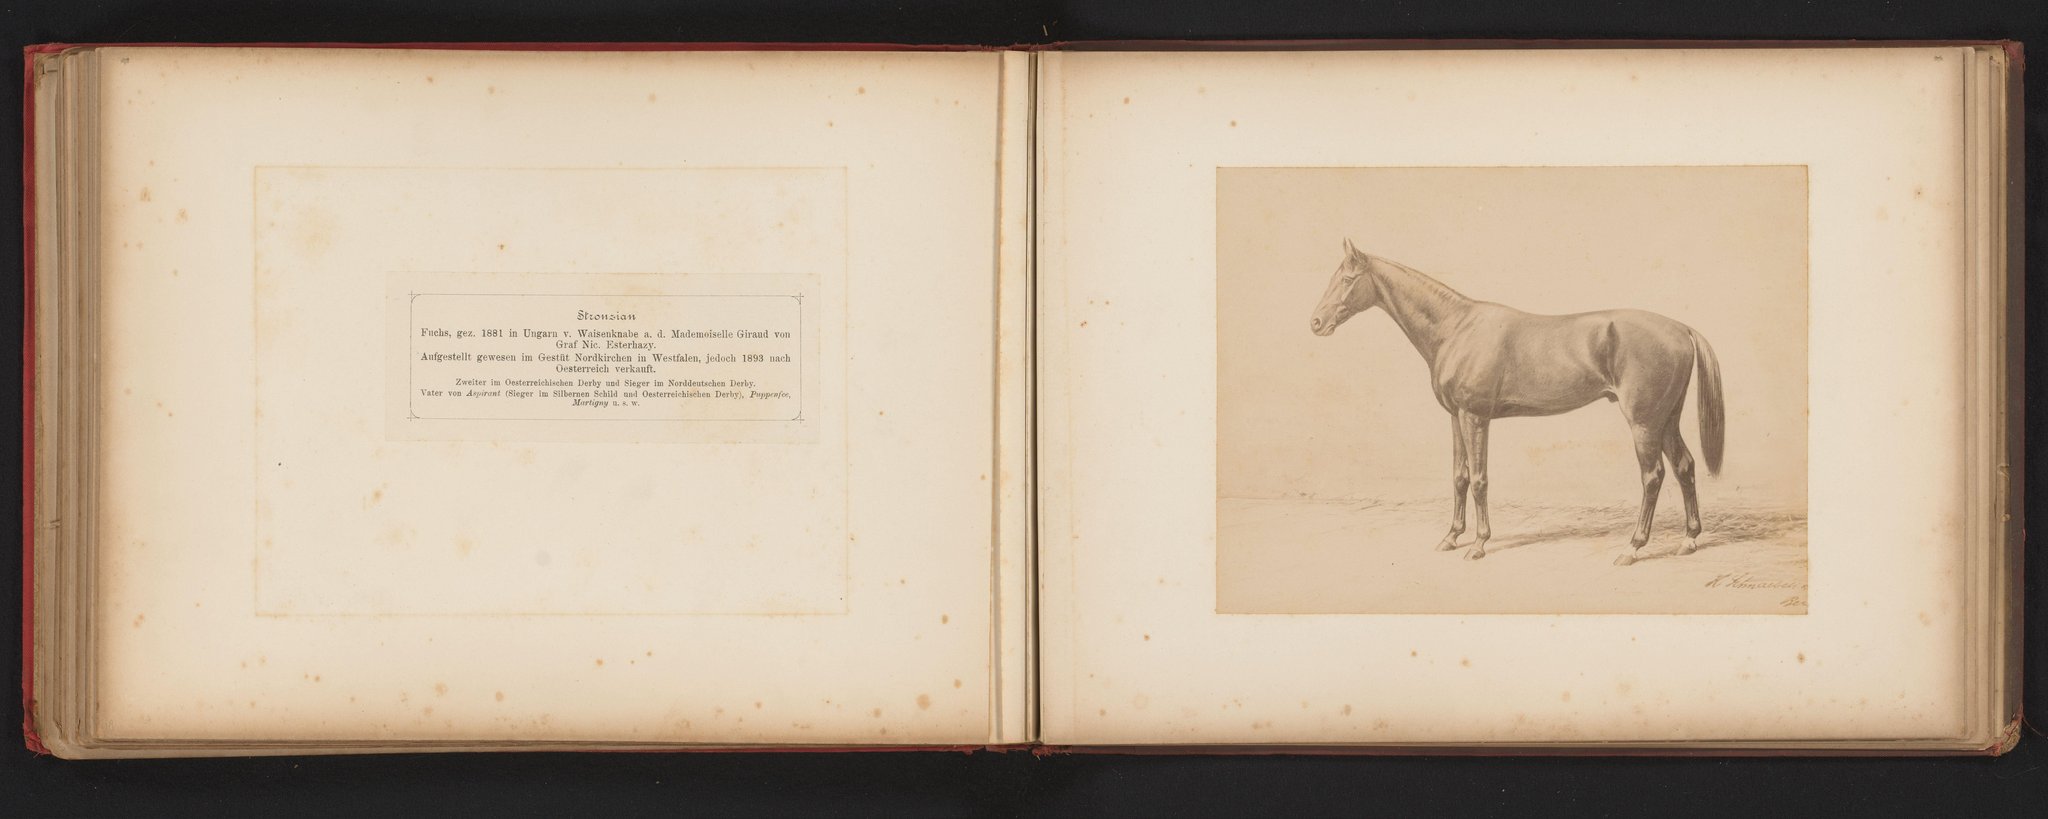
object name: photograph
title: Fotoreproductie van een tekening van een paard, genaamd Stronzian, door H. Schnaebeli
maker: h. schnaebeli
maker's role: fotograaf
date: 1894-1915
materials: photographic support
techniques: albumen print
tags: horse